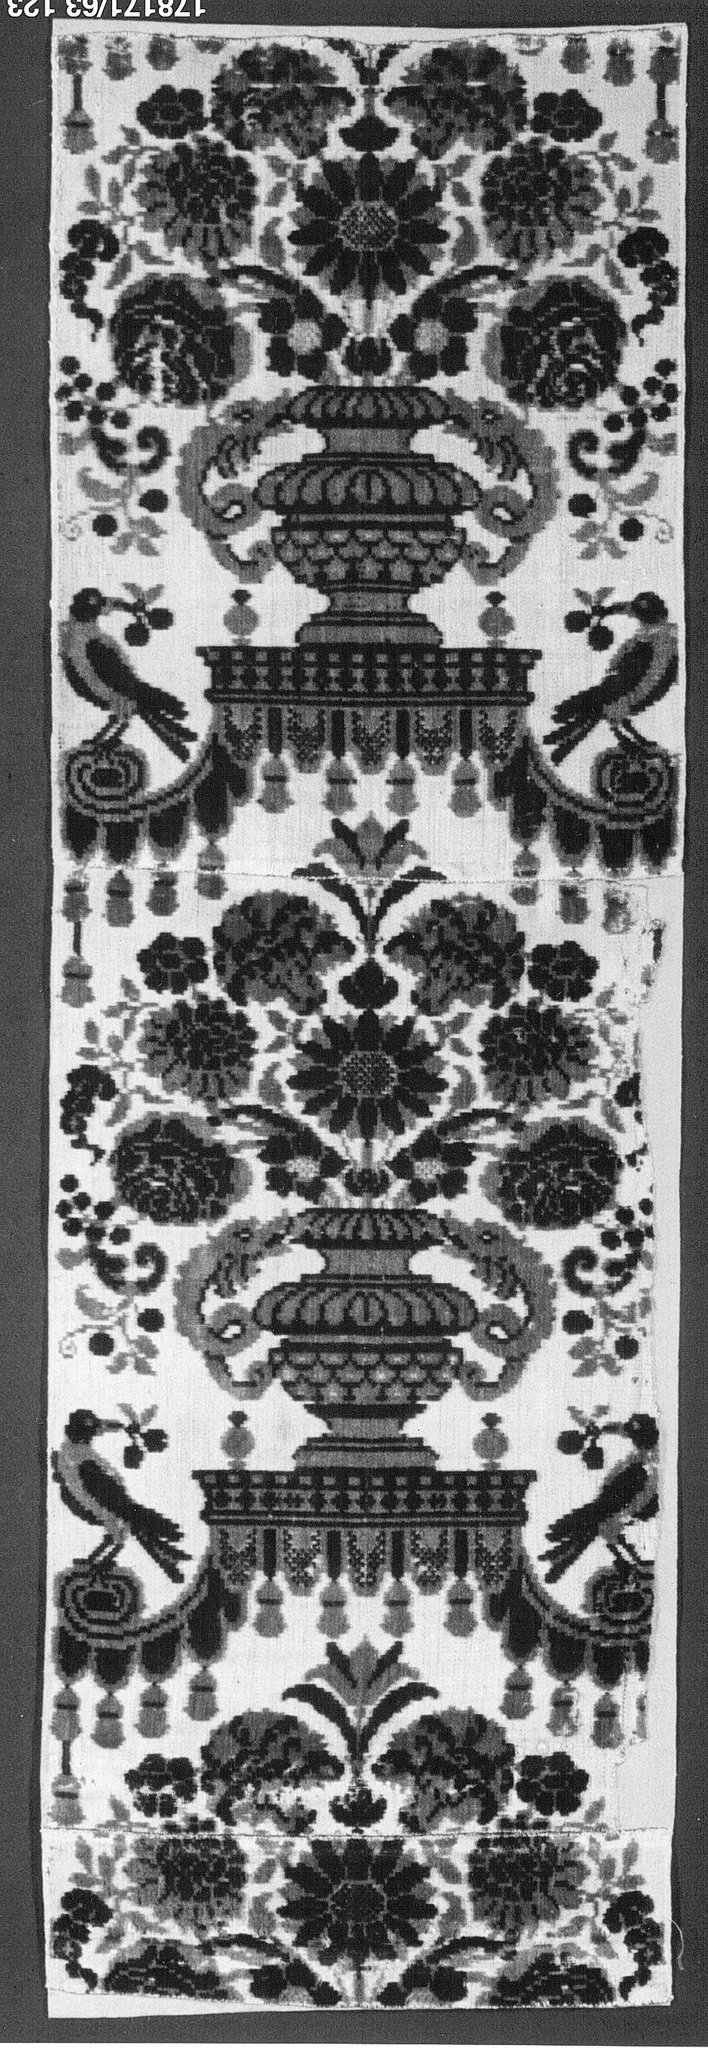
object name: piece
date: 1667-1700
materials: linen, wool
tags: birds,flowers,leaves